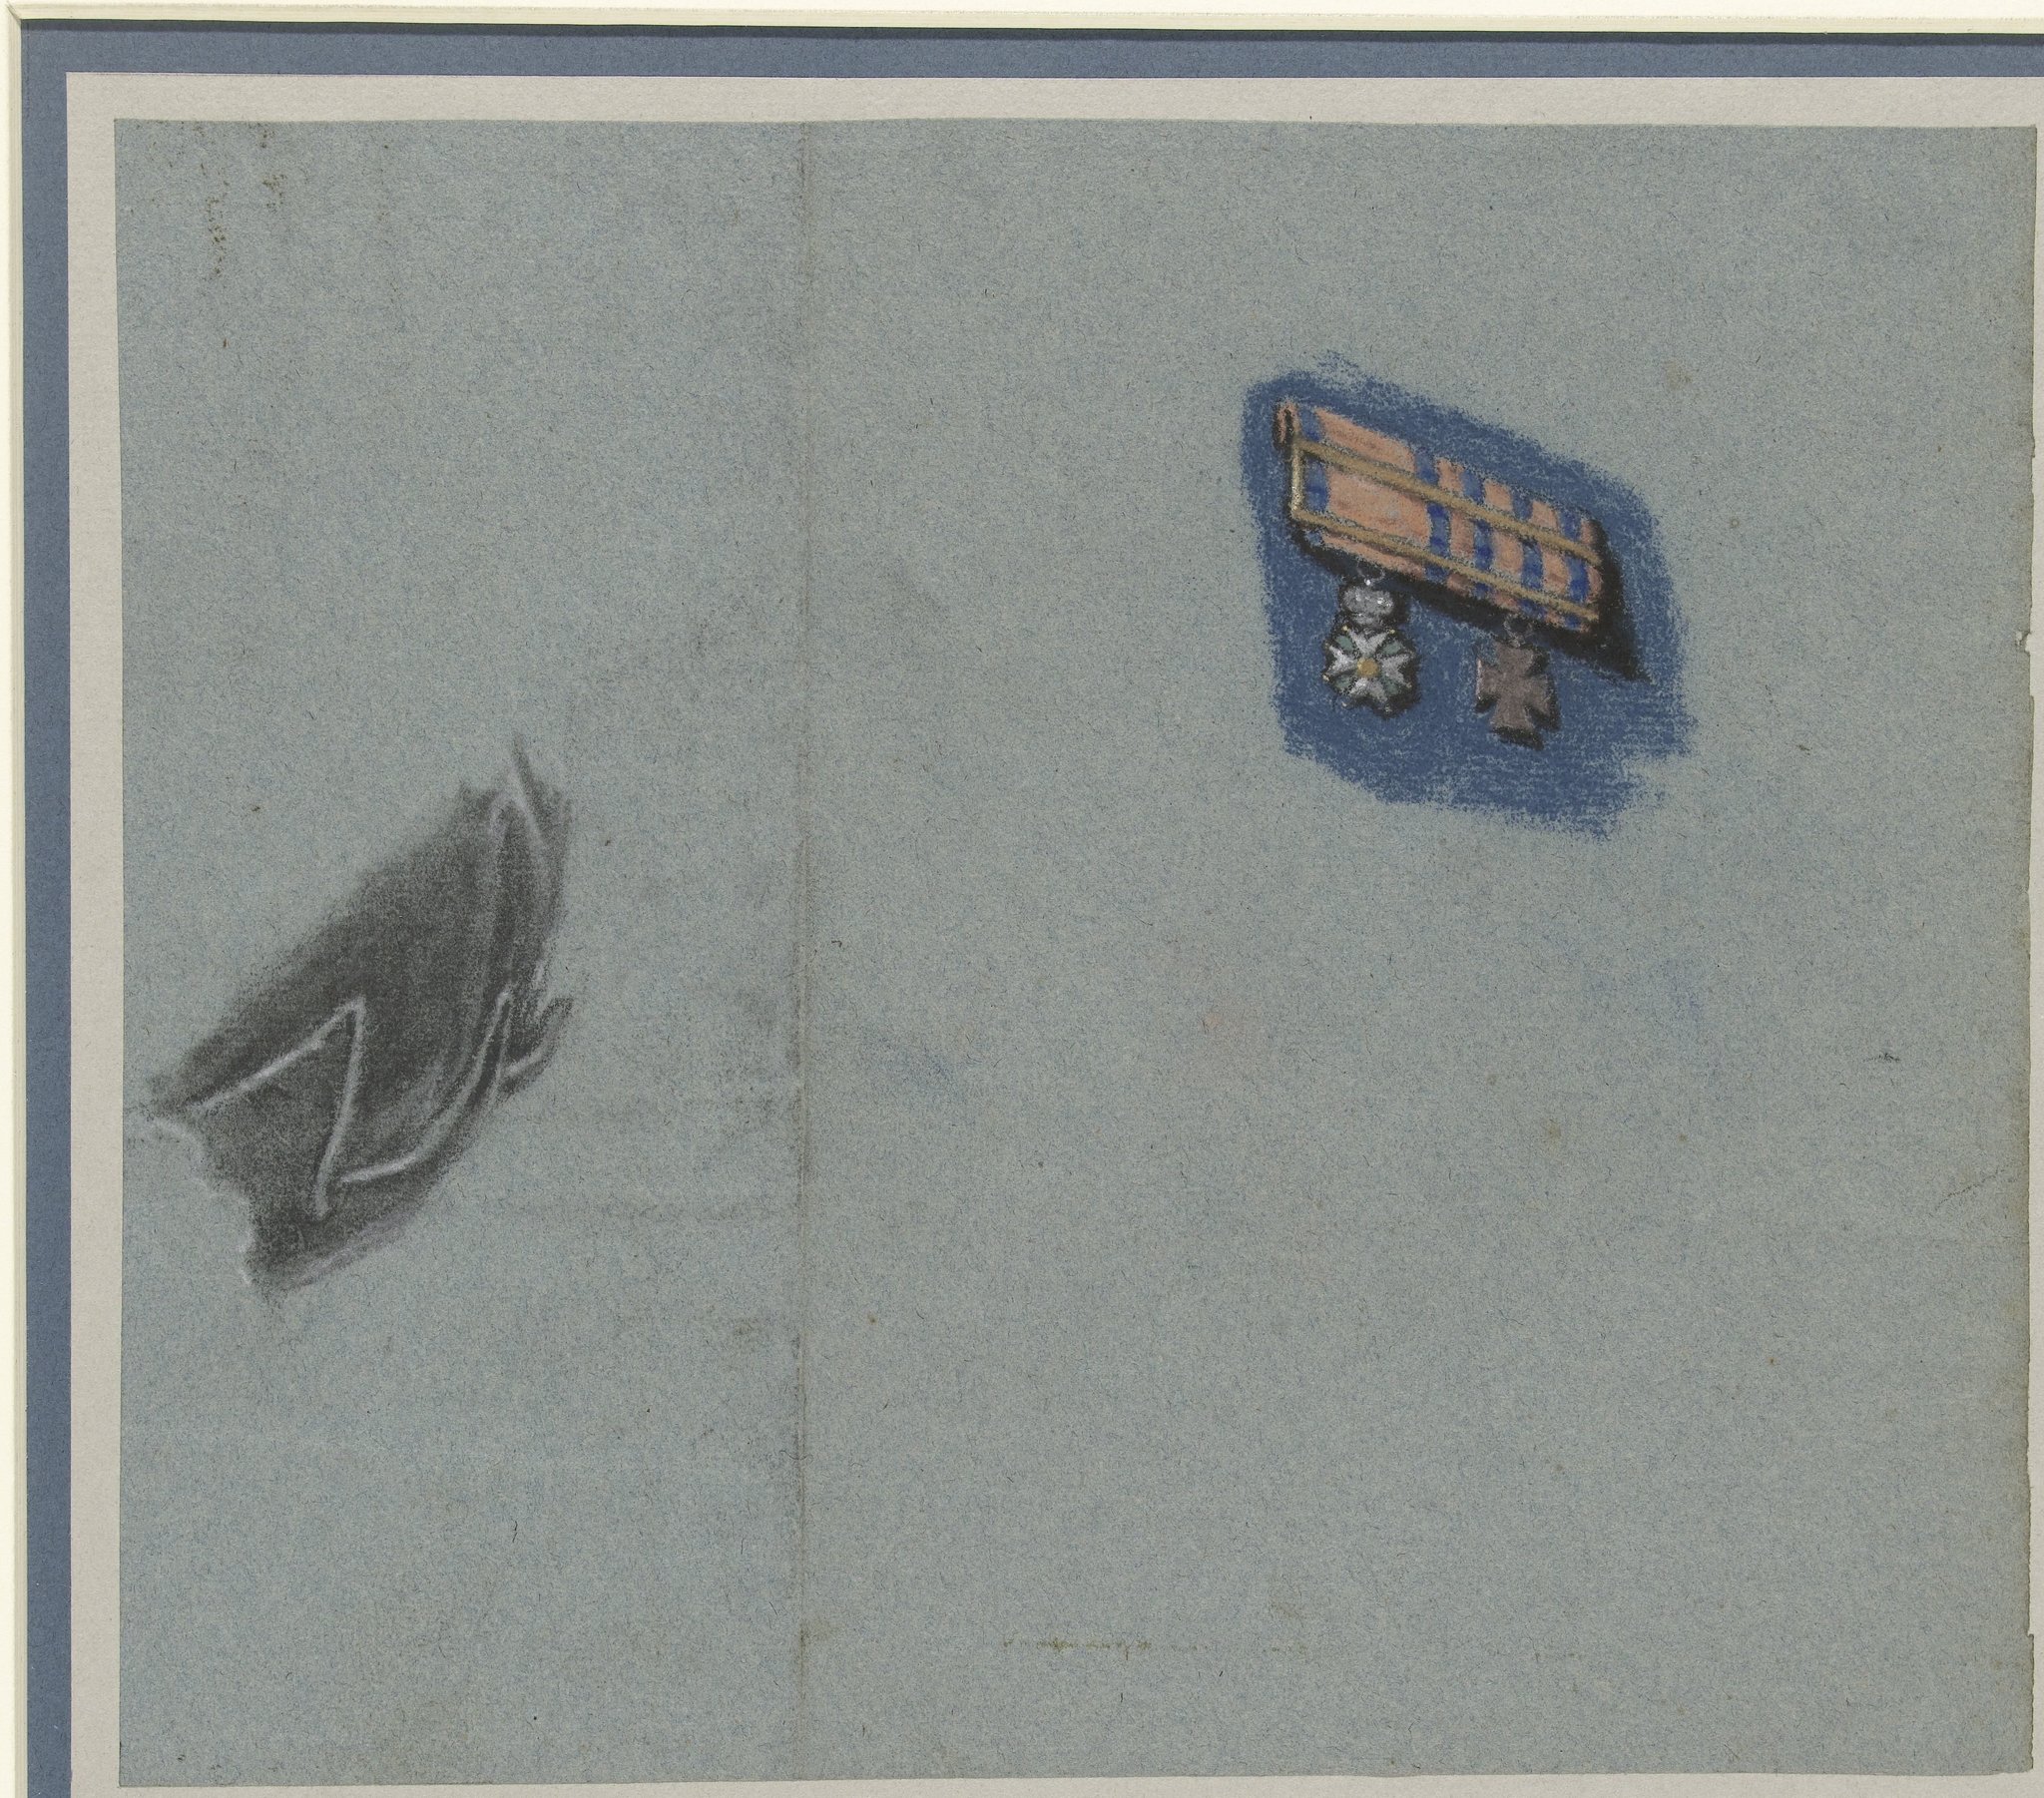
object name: drawing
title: Studies van de Militaire Willems-Orde en het Metalen Kruis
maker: charles howard hodges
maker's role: draughtsman, painter, print maker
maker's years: 1764-1837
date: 1830-1837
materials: paper, pastel